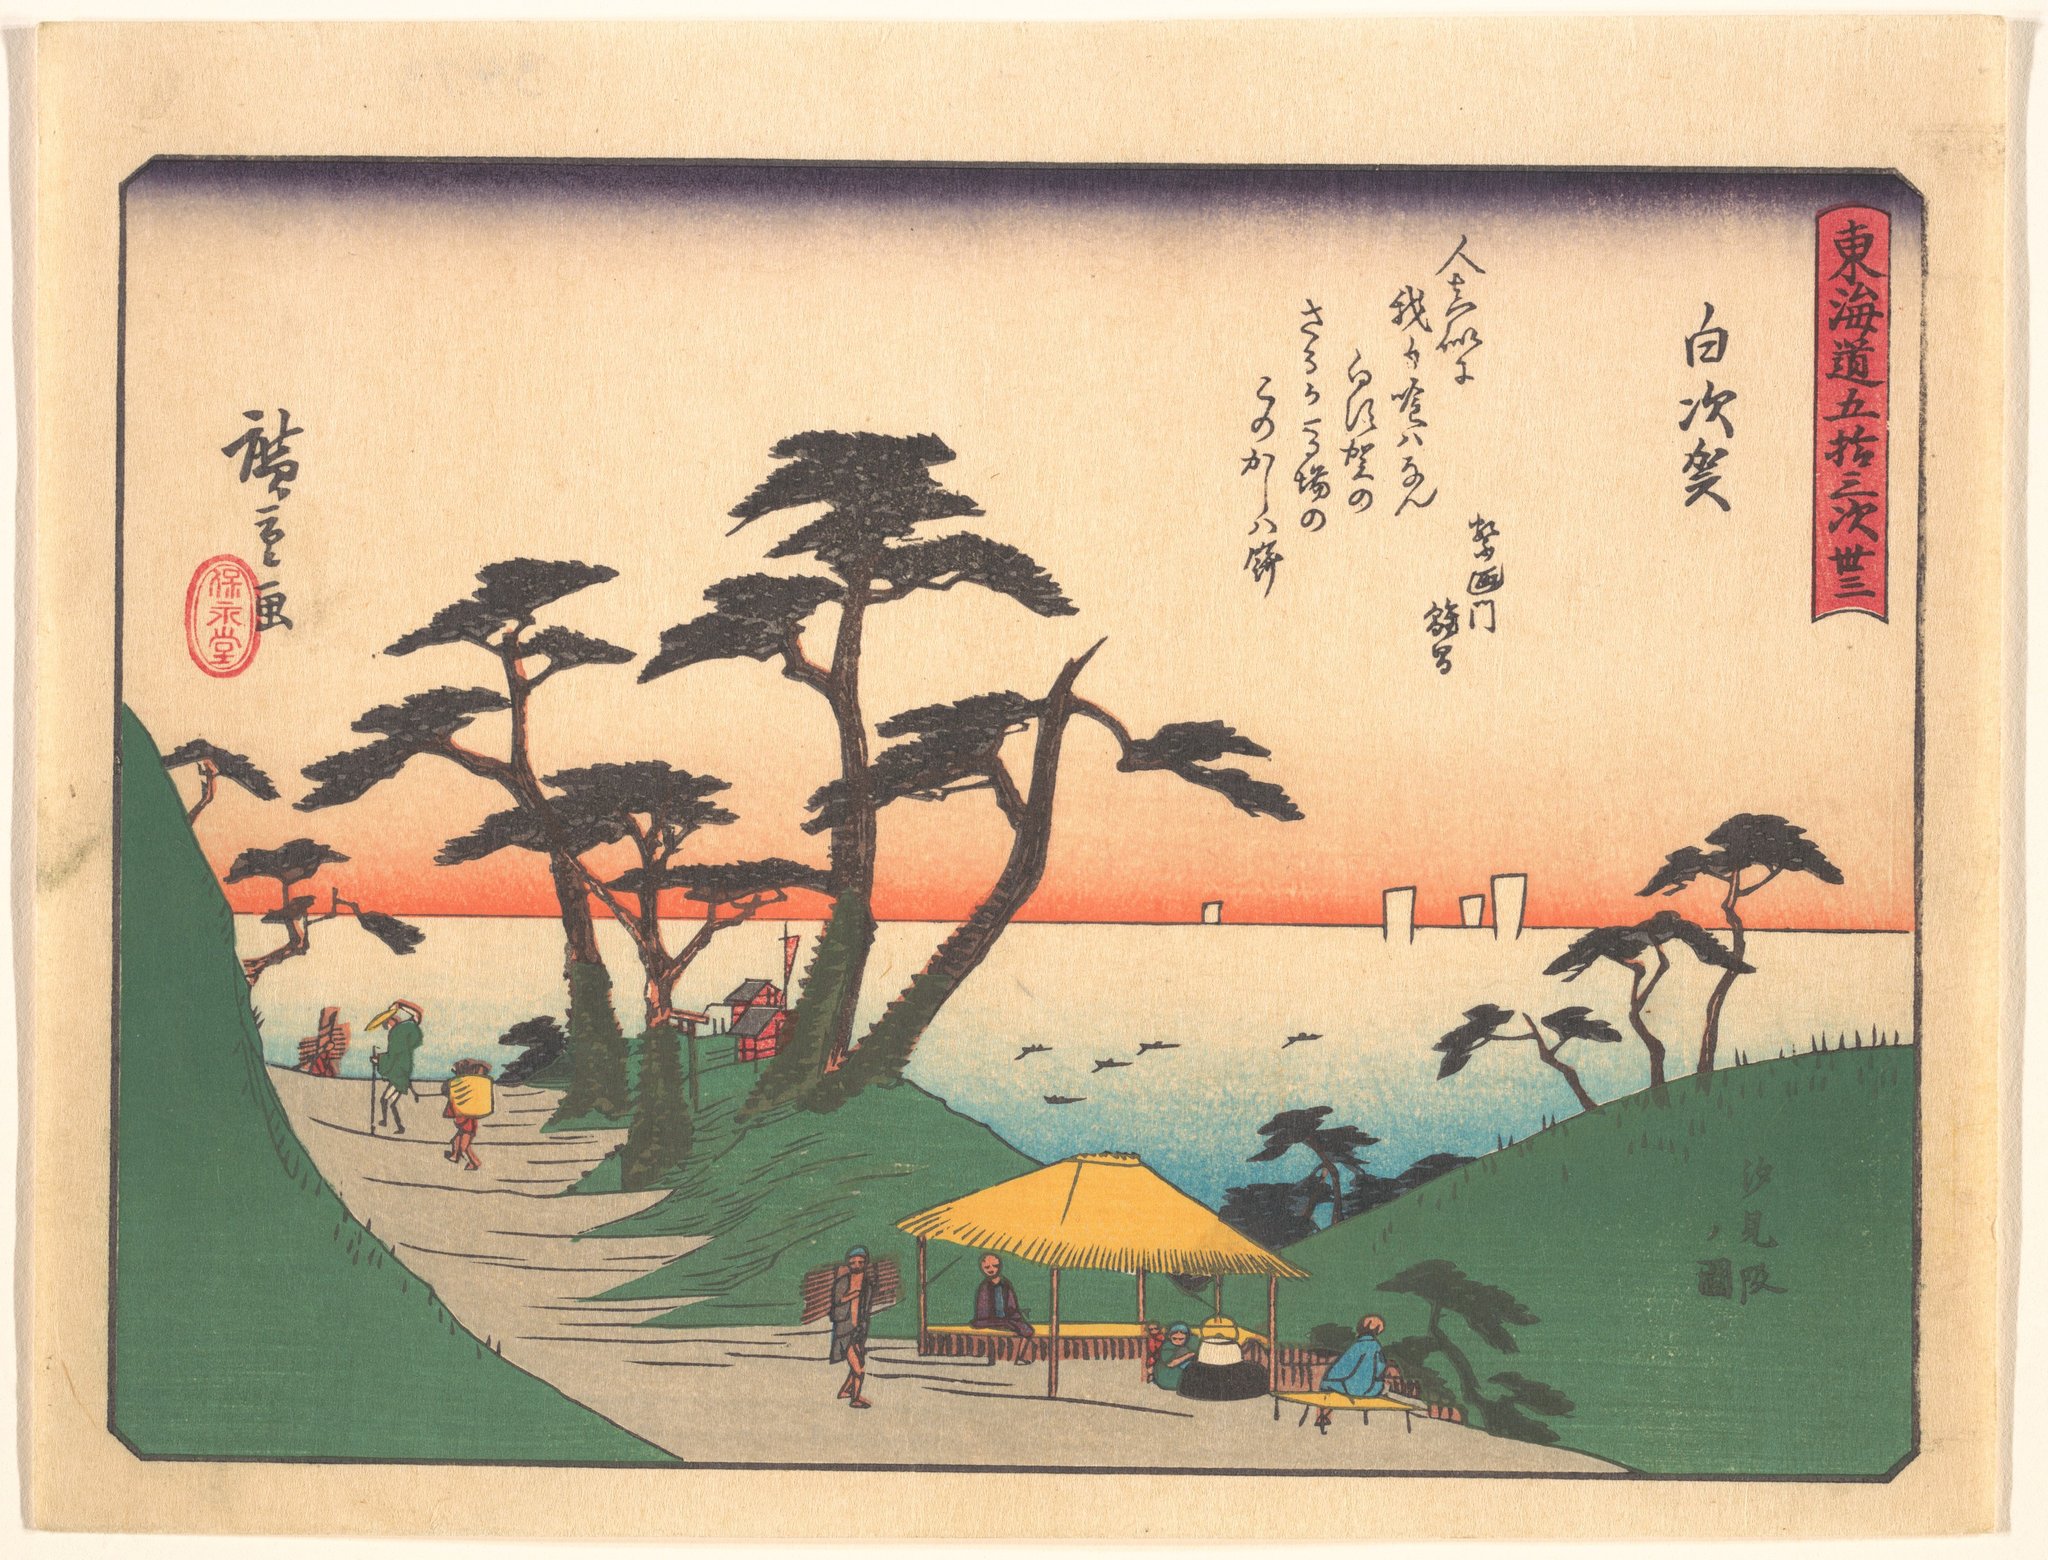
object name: print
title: Shirasuka, from the series The Fifty-three Stations of the Tōkaidō Road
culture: japanese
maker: utagawa hiroshige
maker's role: artist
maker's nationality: japanese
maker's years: 1797-1858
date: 1901-1933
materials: ink, paper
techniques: woodblock print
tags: human figures,roads,trees